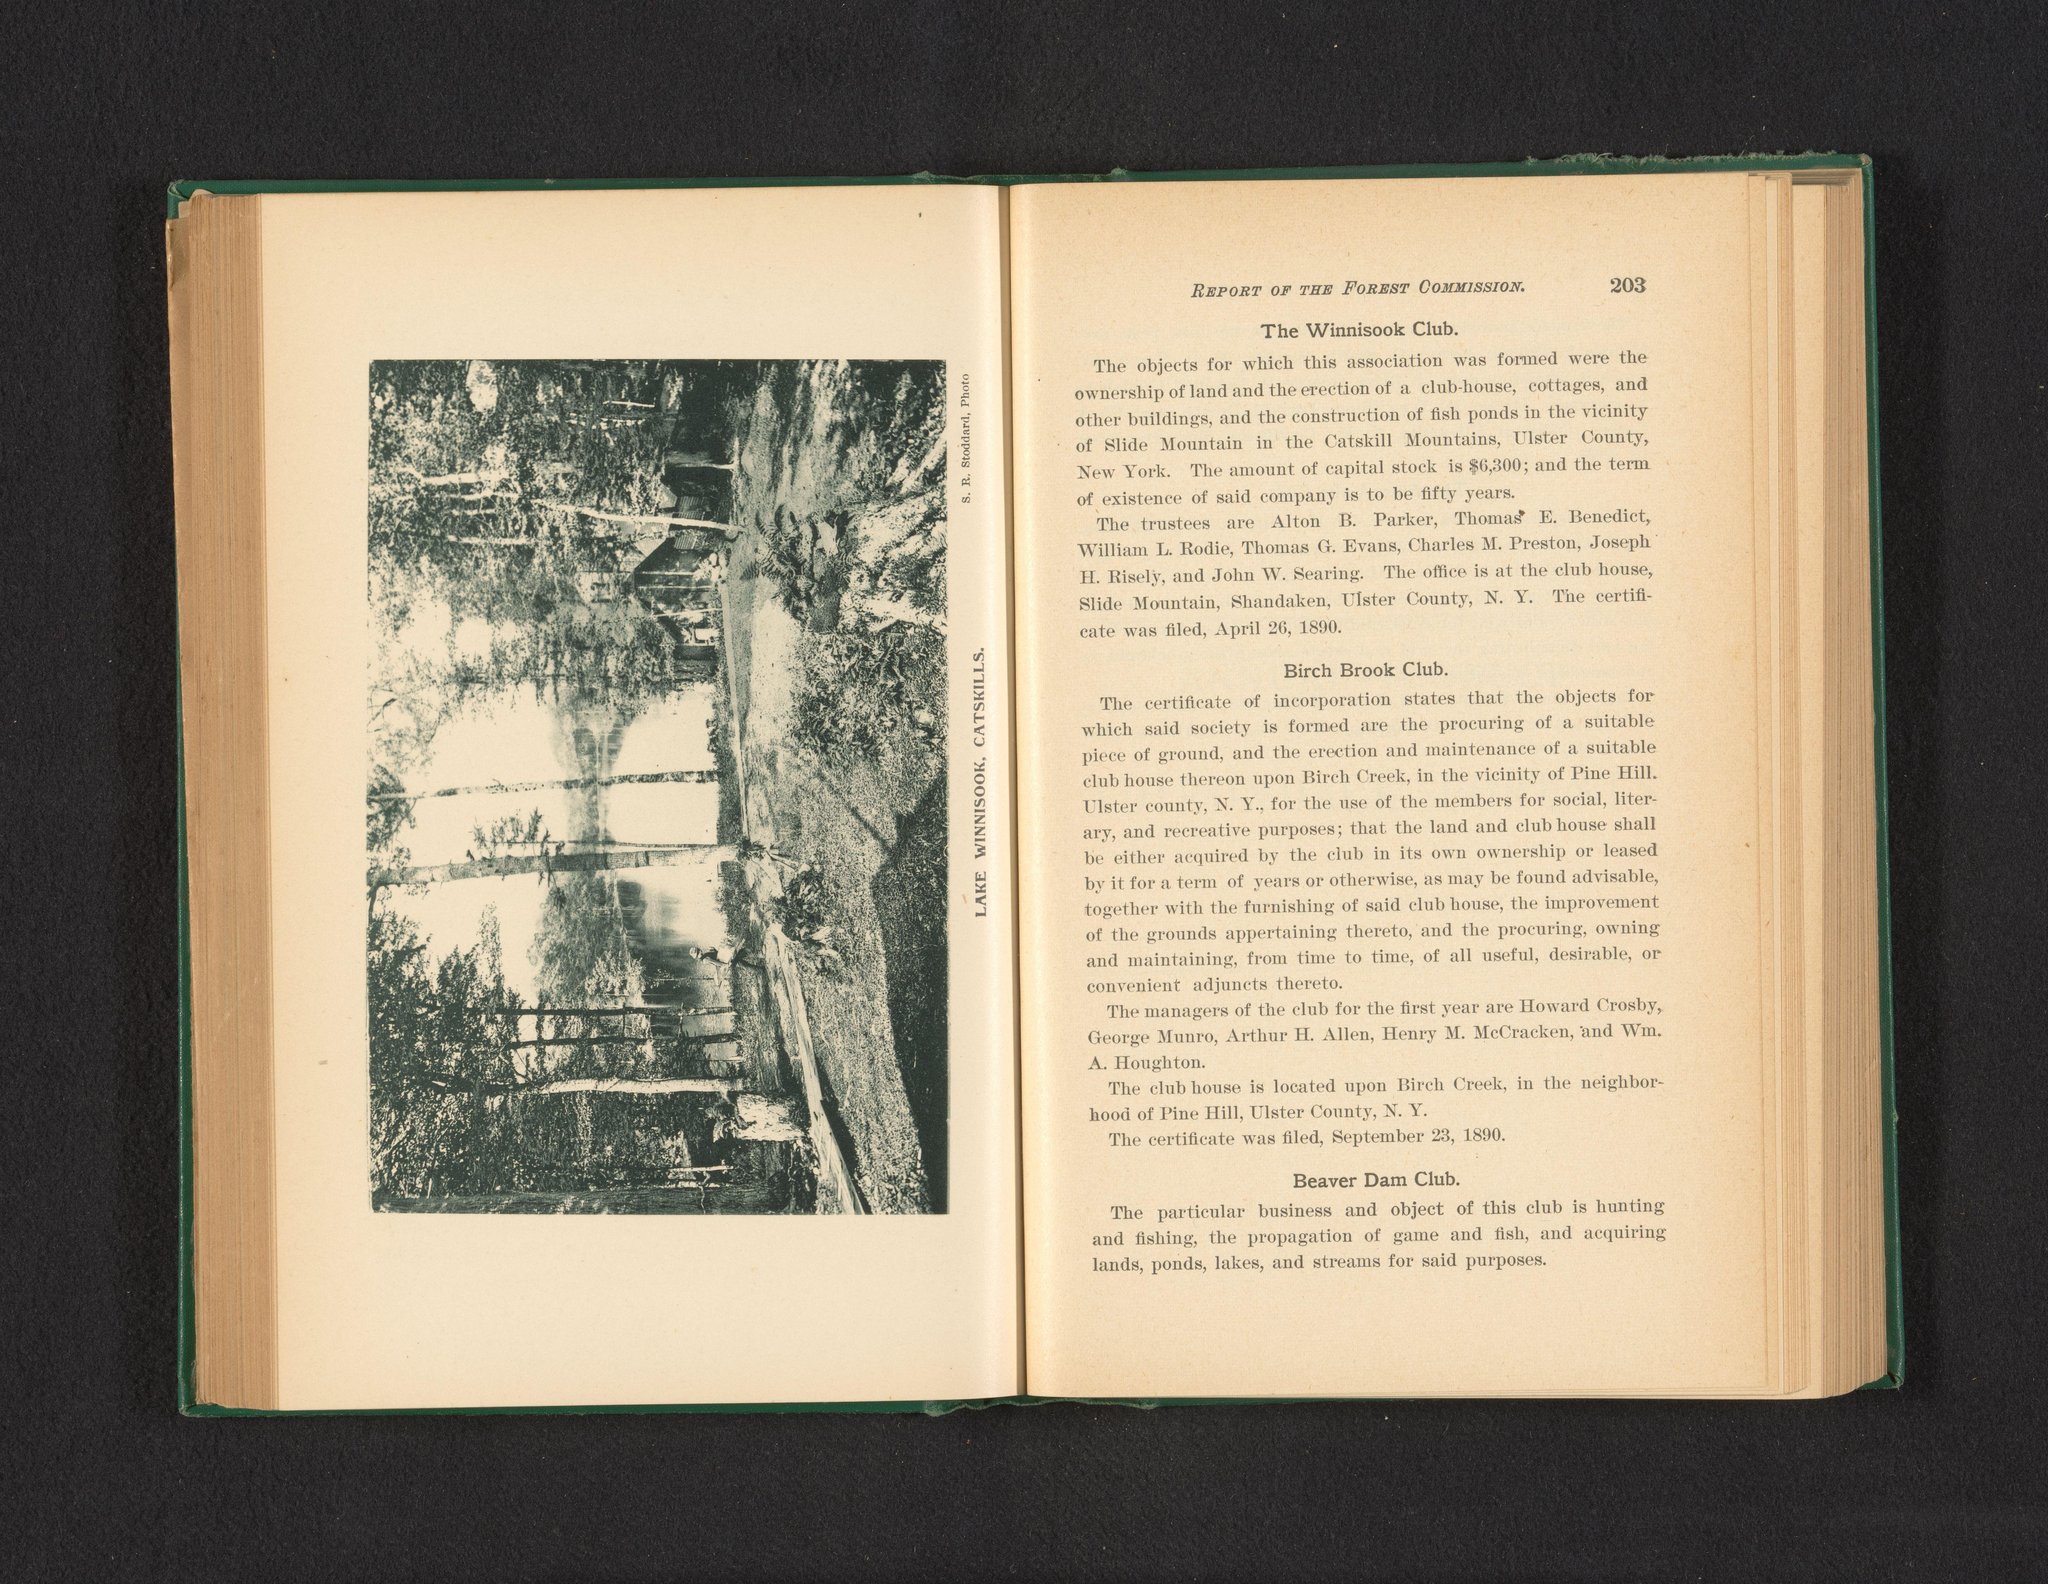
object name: photomechanical print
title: Lake Winnisook, Catskills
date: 1893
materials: paper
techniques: photograph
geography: new york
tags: lake